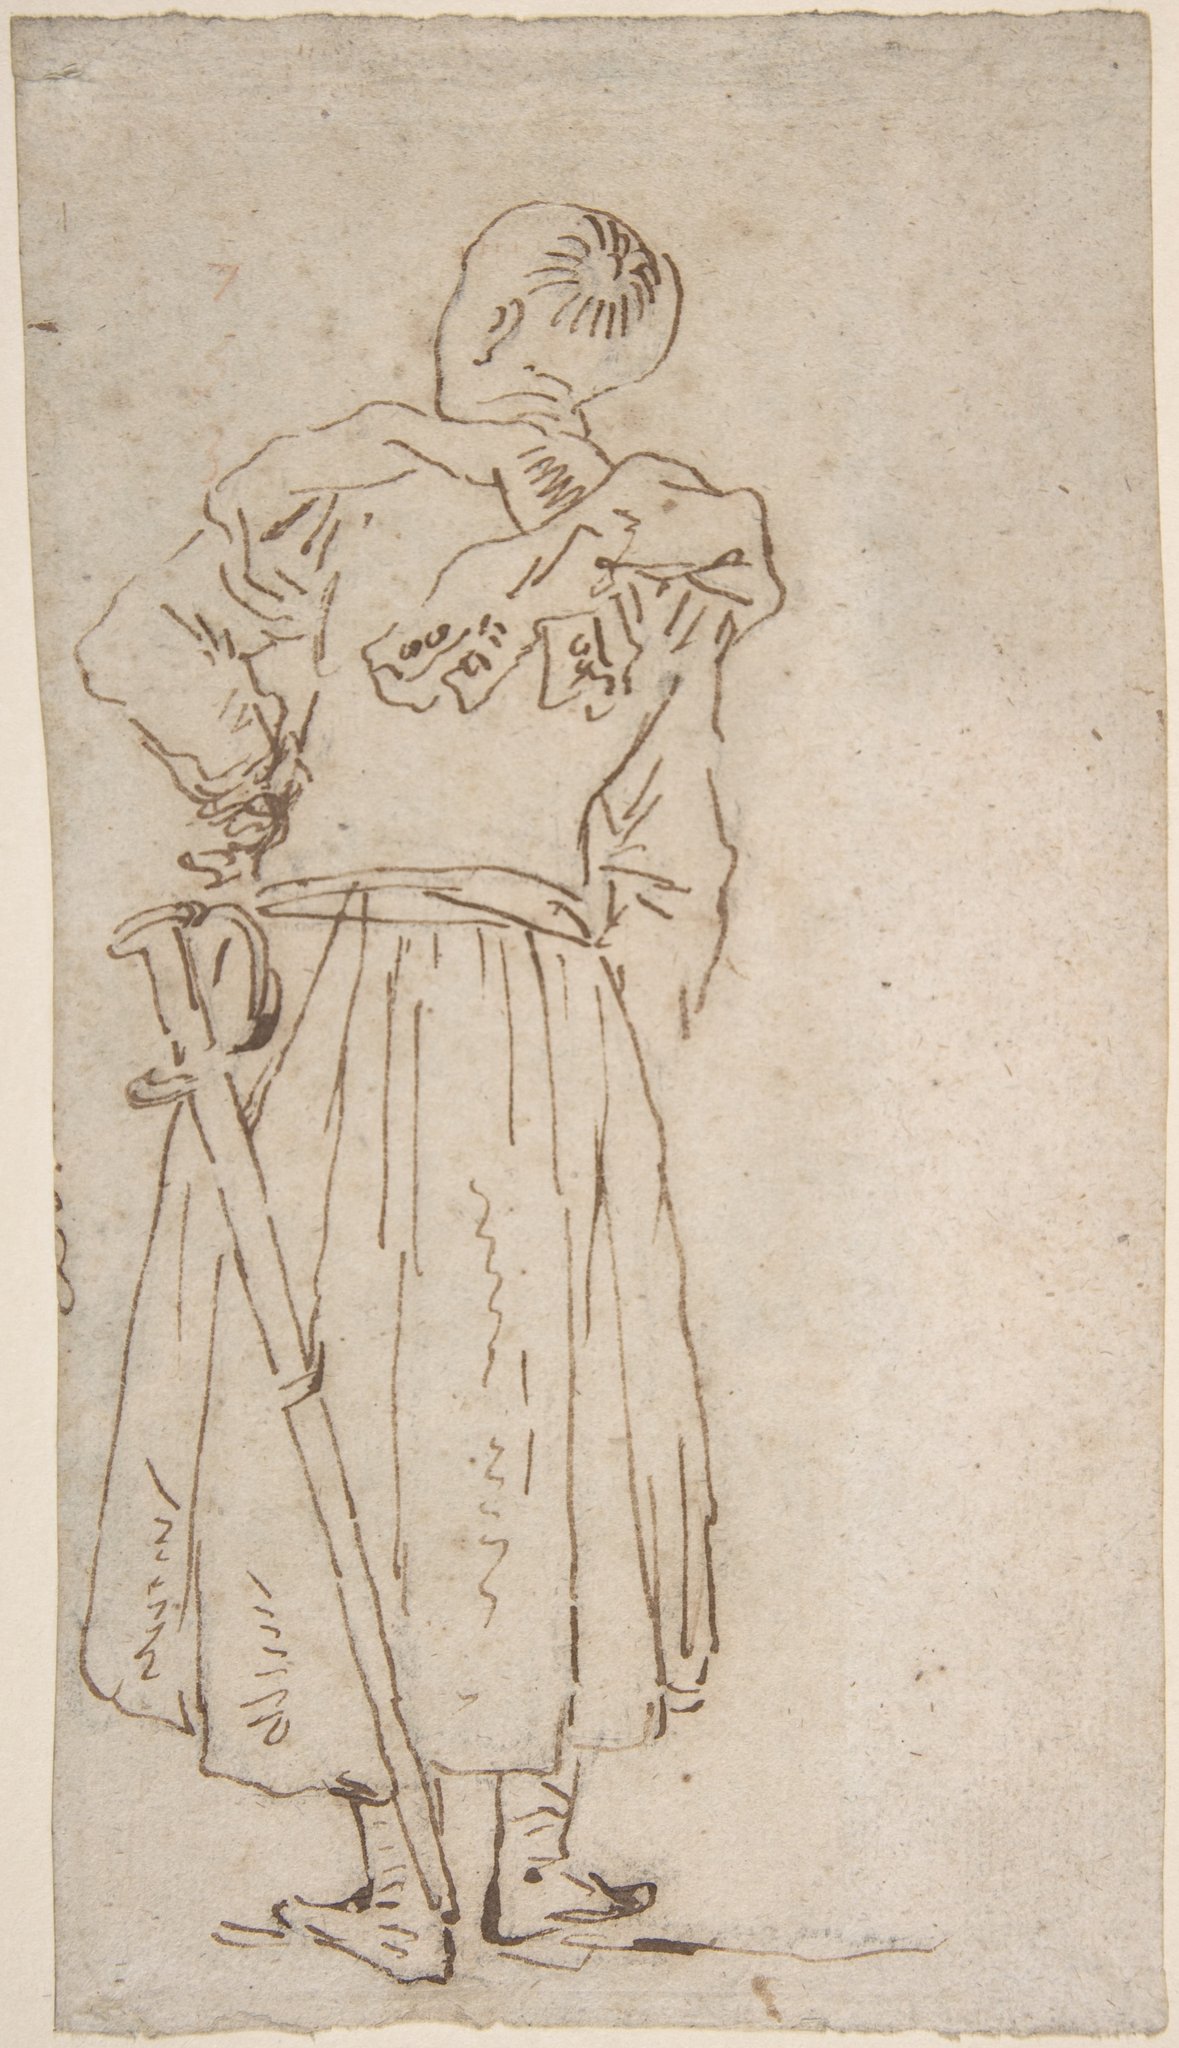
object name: drawing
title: Back View of a Man in a Long Coat with a Sword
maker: anonymous, italian, 18th century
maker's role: artist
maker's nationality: italian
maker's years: 1700-1800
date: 1701-1800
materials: chalk, charcoal, ink, paper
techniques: incising, pen, transfer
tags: men